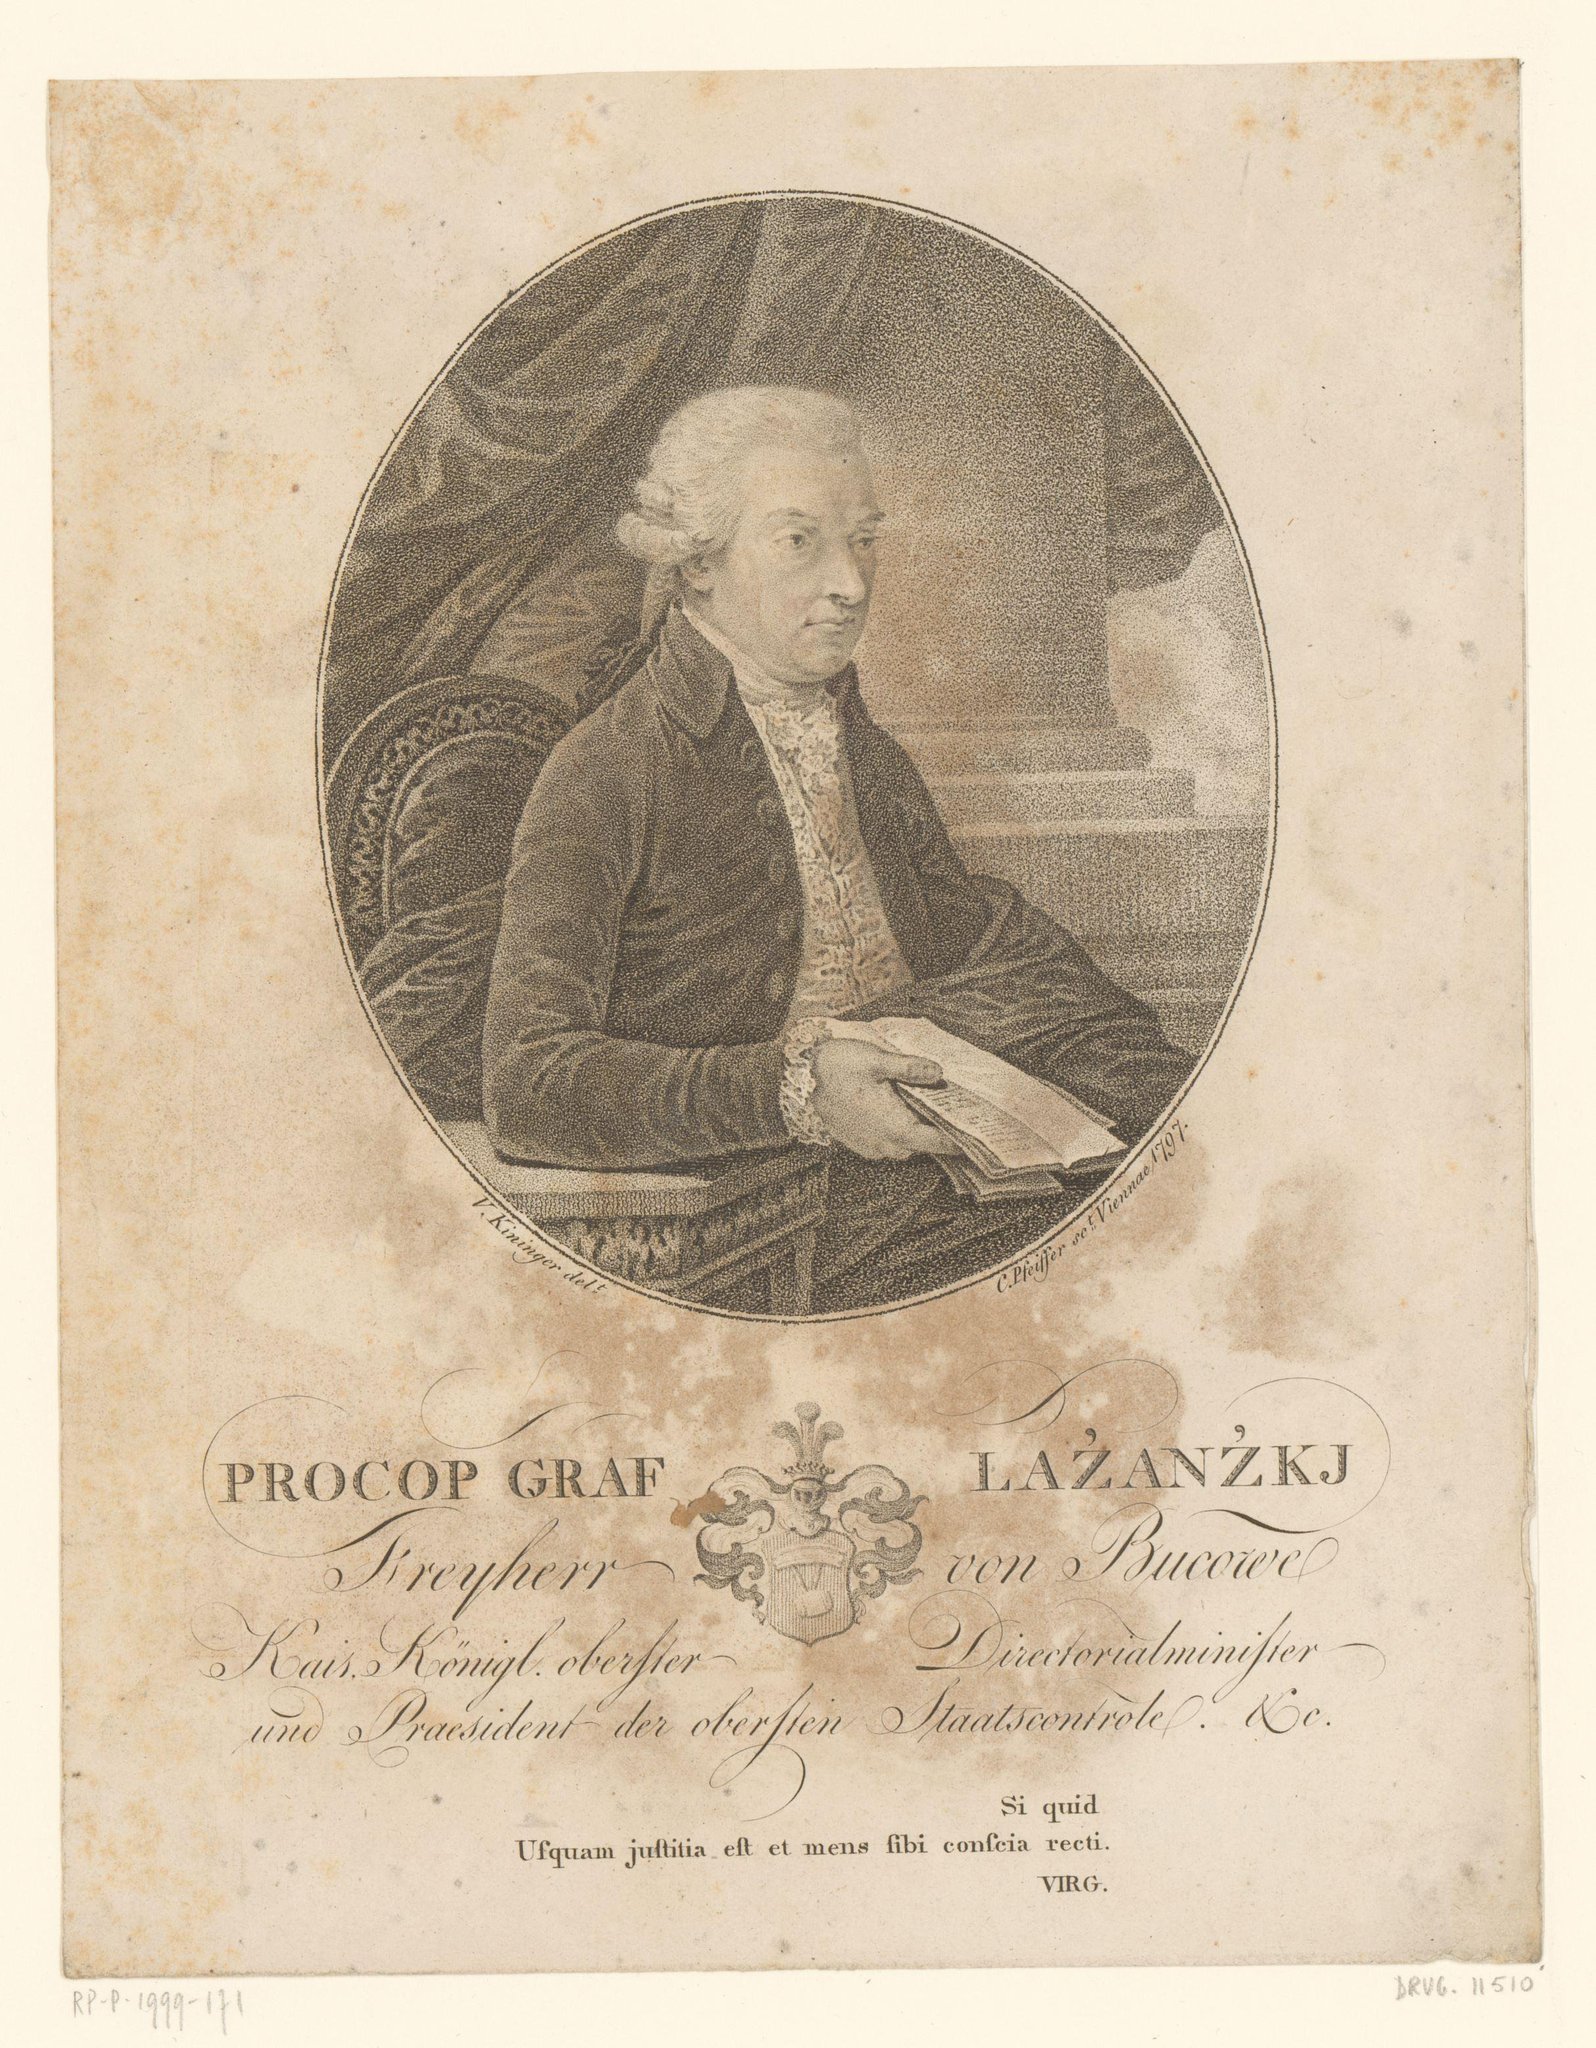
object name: print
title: Portret van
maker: carl hermann pfeiffer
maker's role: print maker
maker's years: 1769-1829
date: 1779-1829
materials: paper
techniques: engraving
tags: historical persons, letter, envelope, armorial bearing, heraldry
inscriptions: collector's mark: Lugt 2228, collector's mark: Lugt 2760 waller